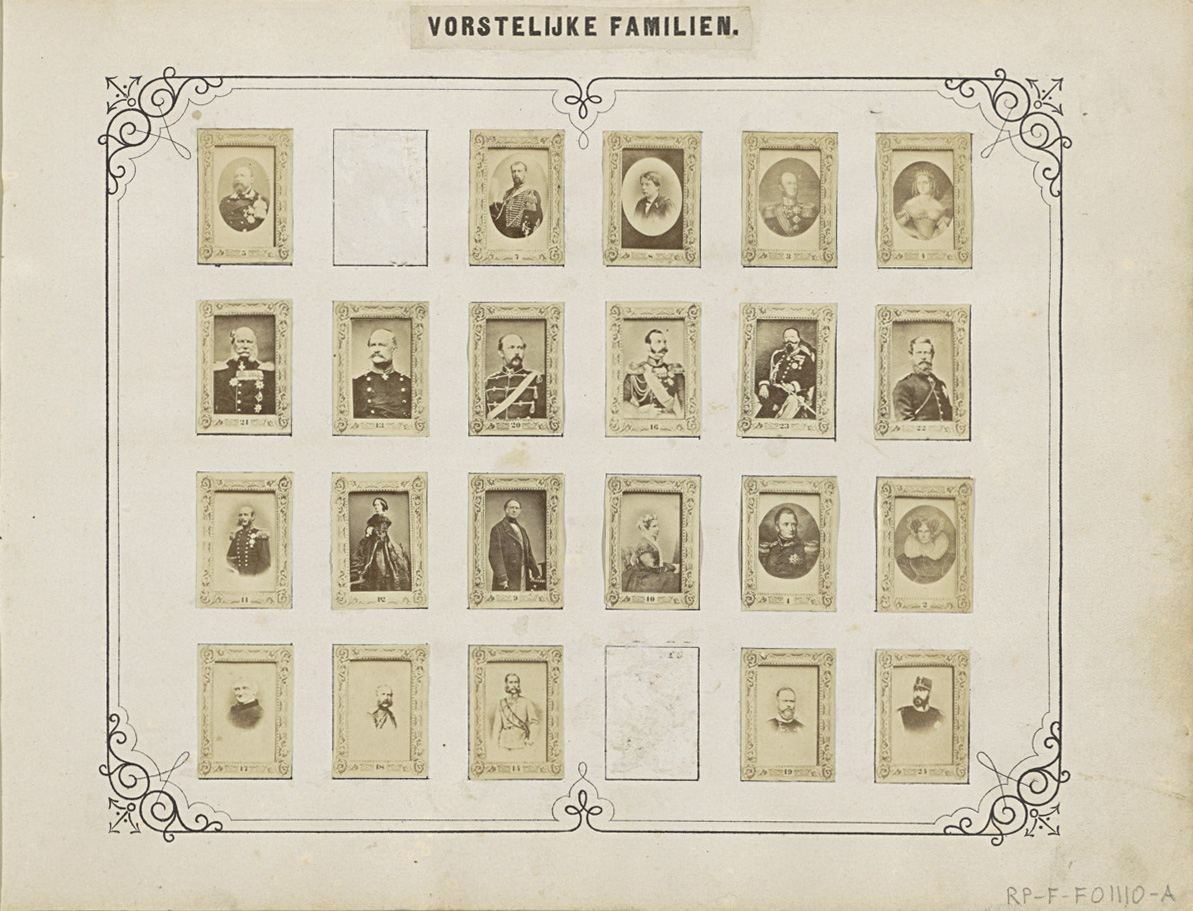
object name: album leaf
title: Vorstelijke familien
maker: Anonymous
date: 1872-1875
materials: paper, photographic support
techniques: albumen print, writing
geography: haarlem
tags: vienna, prague, ferdinand i (keizer van oostenrijk), anna paulowna romanowa, print maker, wilhelmina of the netherlands, berlin, wilhelm i (keizer van duitsland), rome, william i of the netherlands, willem iii (koning der nederlanden), willem (prins der nederlanden), the hague, william ii of the netherlands, hendrik (prins der nederlanden), sophia frederika mathilda van württemberg, frederik (prins der nederlanden), series of rulers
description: Onderdeel van Regnib's miniaturenalbum van vorsten, beroemdheden en historische en fantasietaferelen.